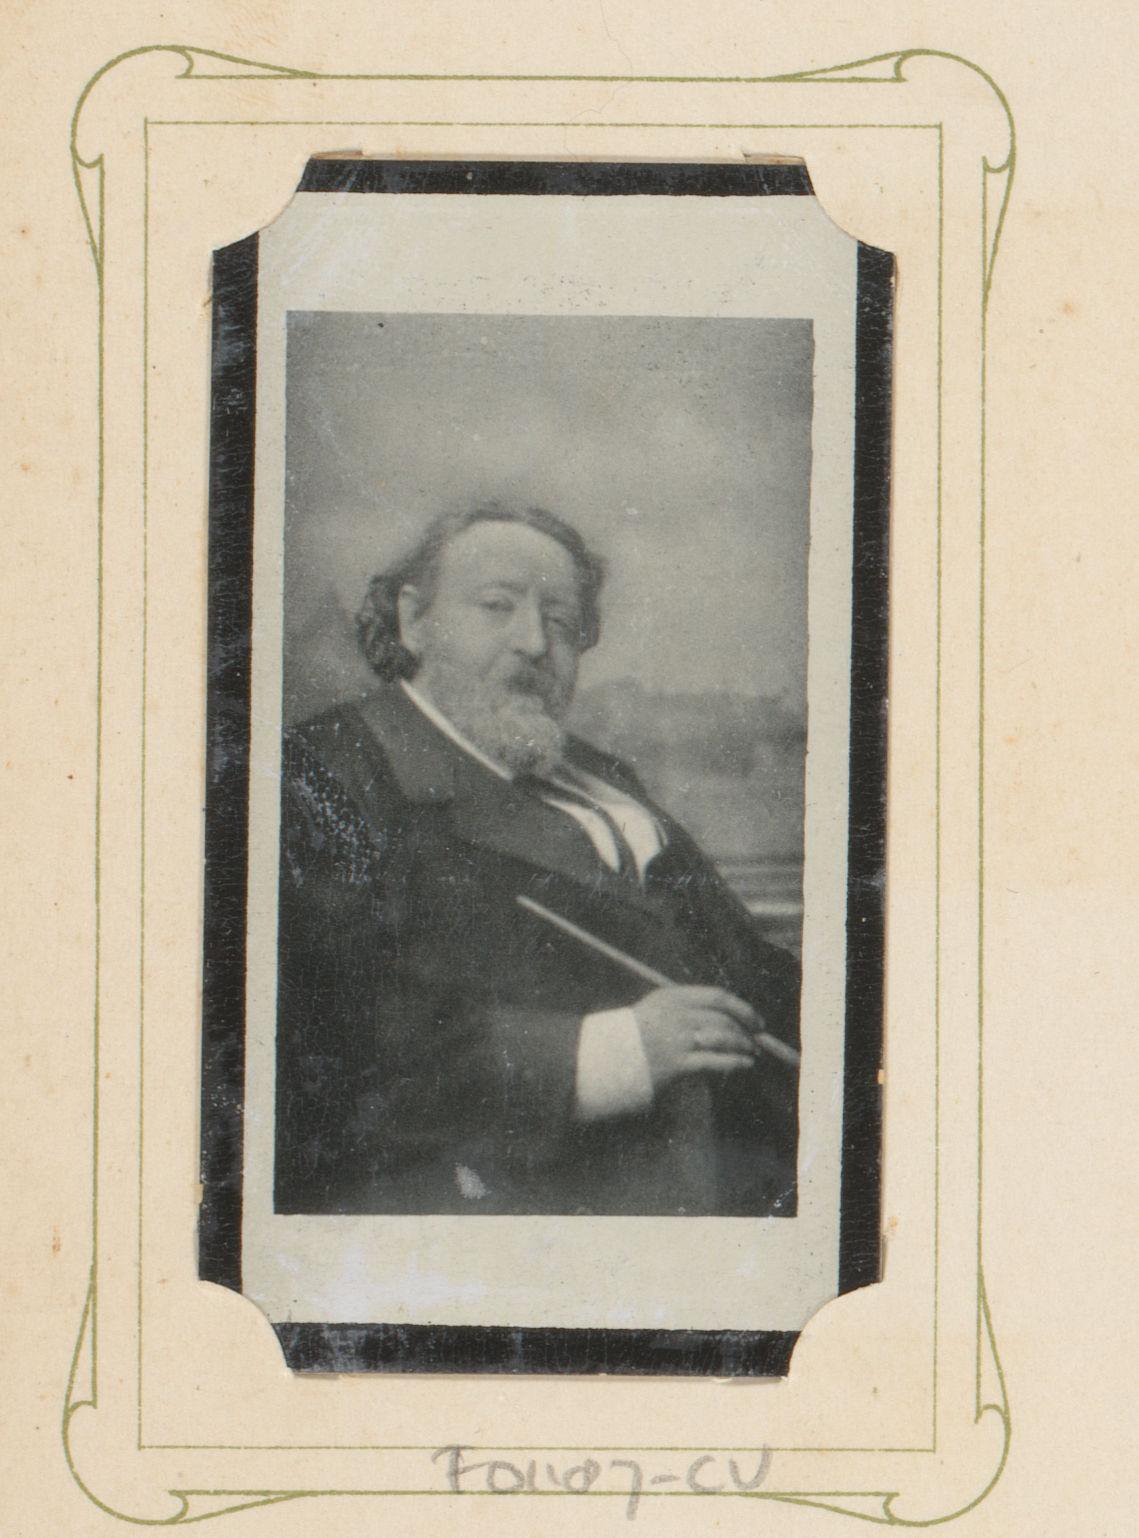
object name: photomechanical print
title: Portret van Jacob Maris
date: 1905-1906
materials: paper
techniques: photograph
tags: the hague, jacob maris, historical persons, portrait, self-portrait of painter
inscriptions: inscription: ‘No. 1./ Jacob Maris.’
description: Deze prent maakt deel uit van een album.